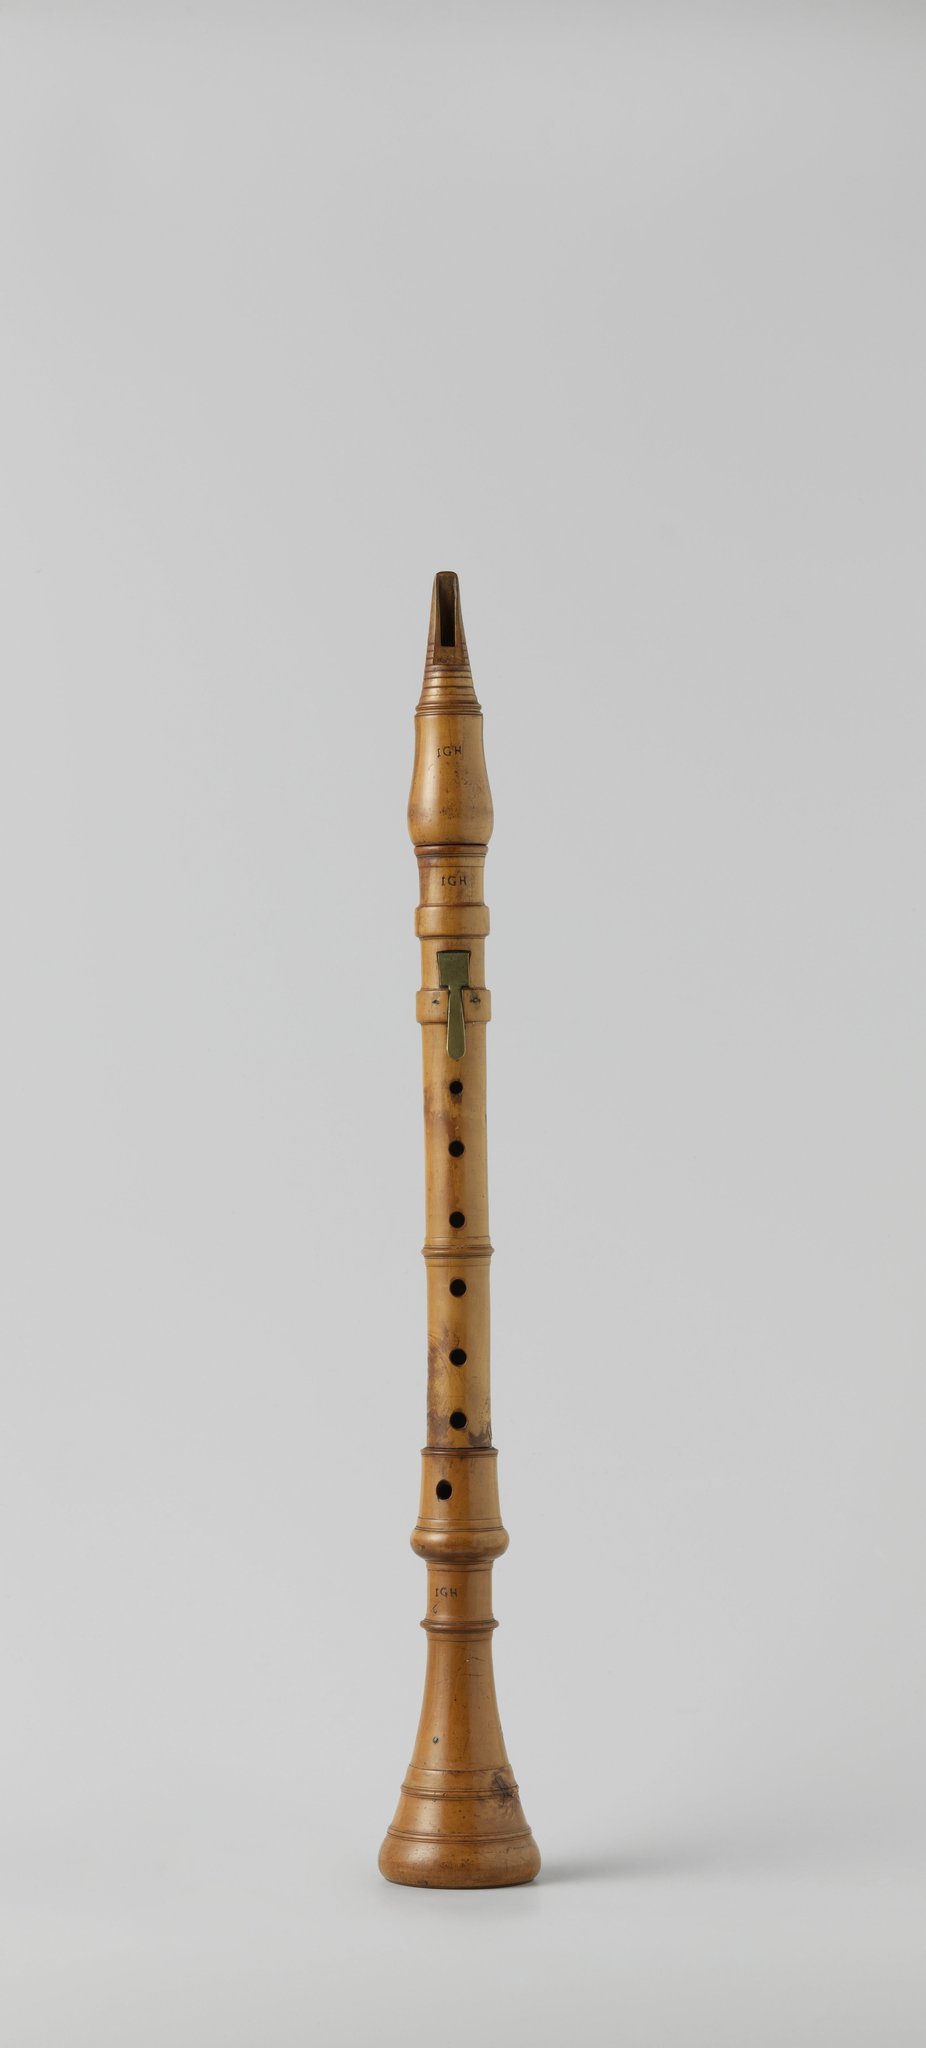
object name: clarinet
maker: johann gottfied heintze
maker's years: 1762-1823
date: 1750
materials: wood, brass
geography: leipzig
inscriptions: monogram, on the barrel, upper joint and on the bell, stamped: ‘IGH’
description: Klarinet van buxushout met twee kleppen. Gemerkt IGH.